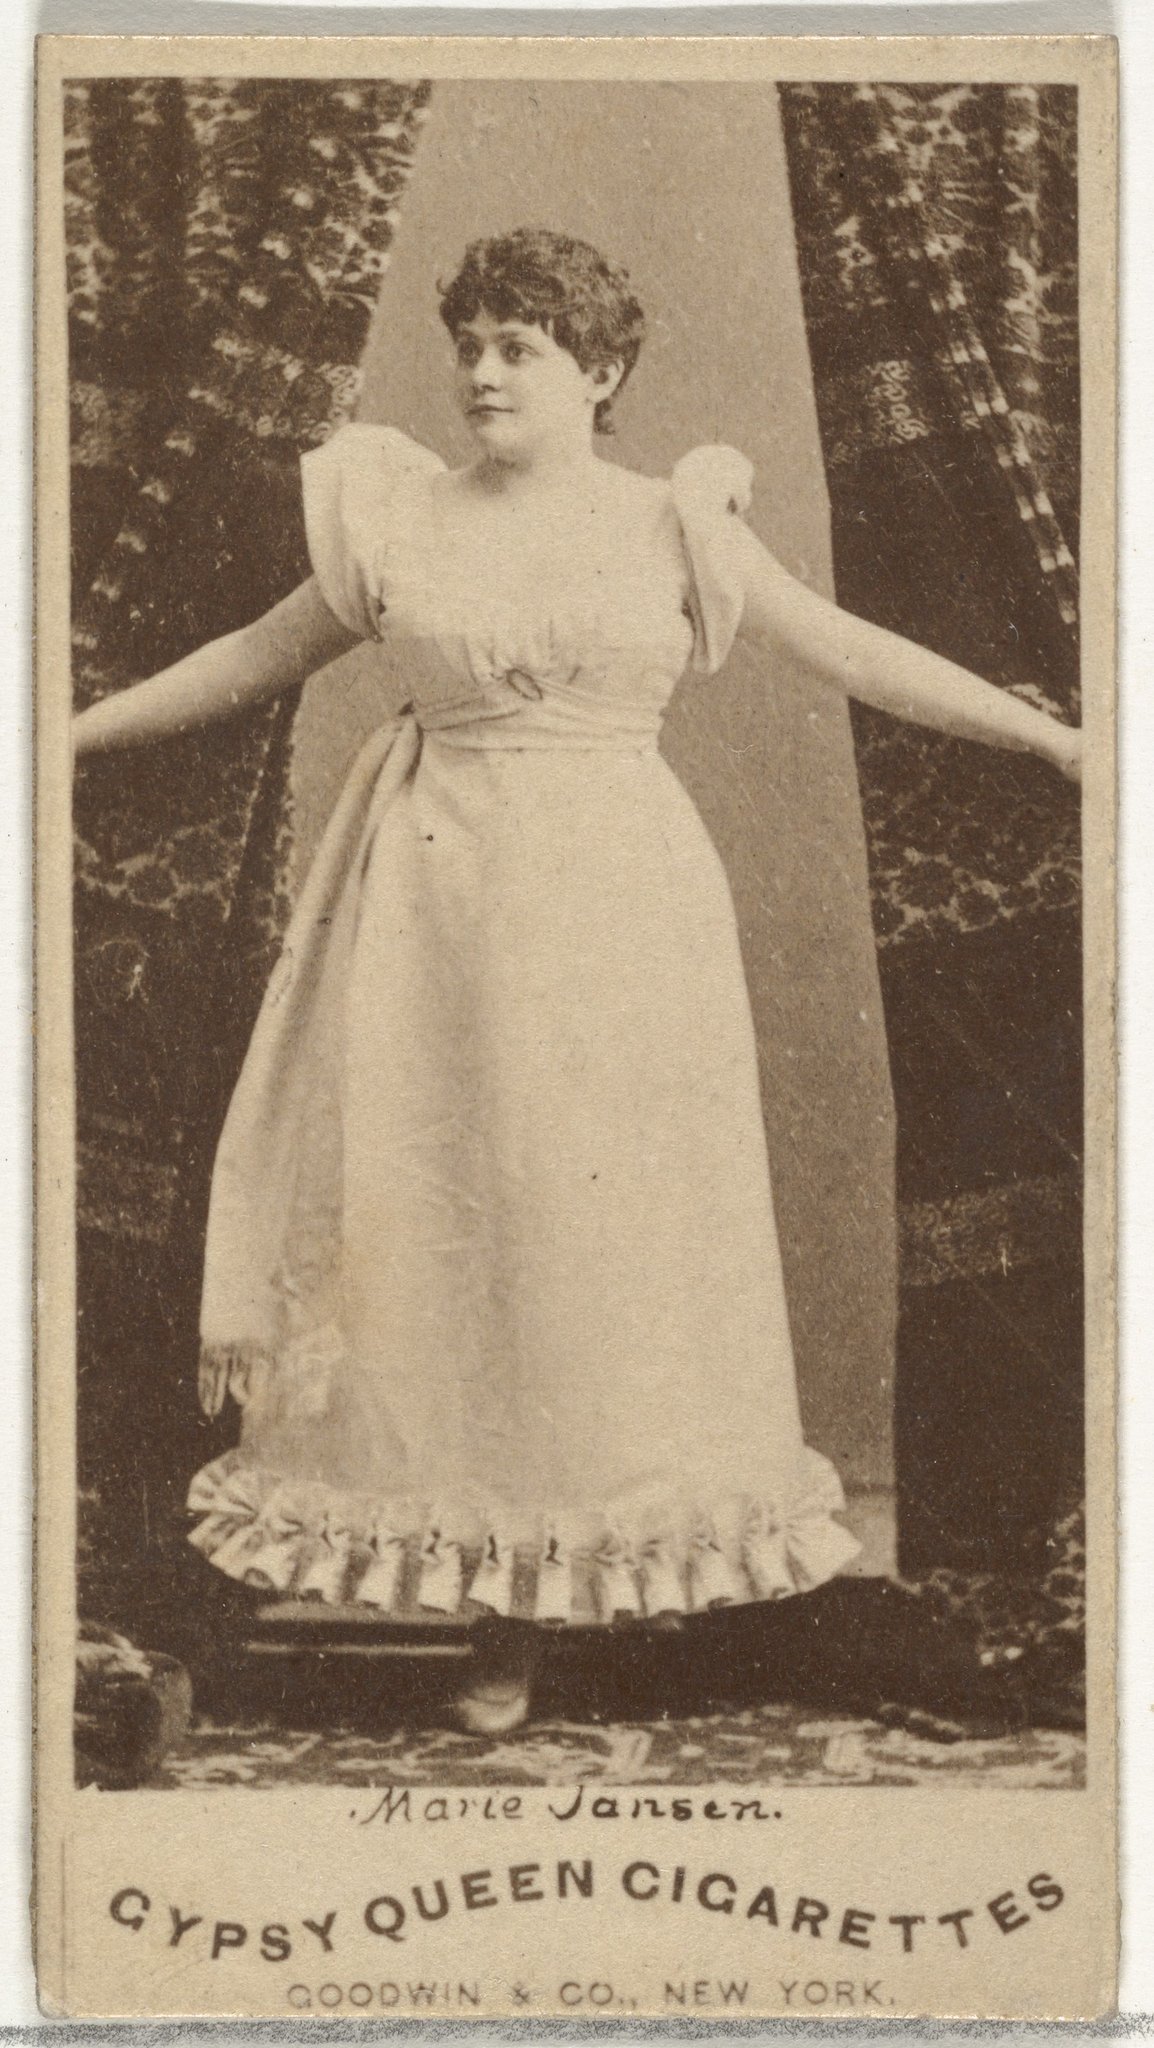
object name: photograph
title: Marie Jansen, from the Actors and Actresses series (N171) for Gypsy Queen Cigarettes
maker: goodwin & company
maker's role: publisher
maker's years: 1850-1950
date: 1886-1890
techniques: albumen silver print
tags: portraits,women,actresses